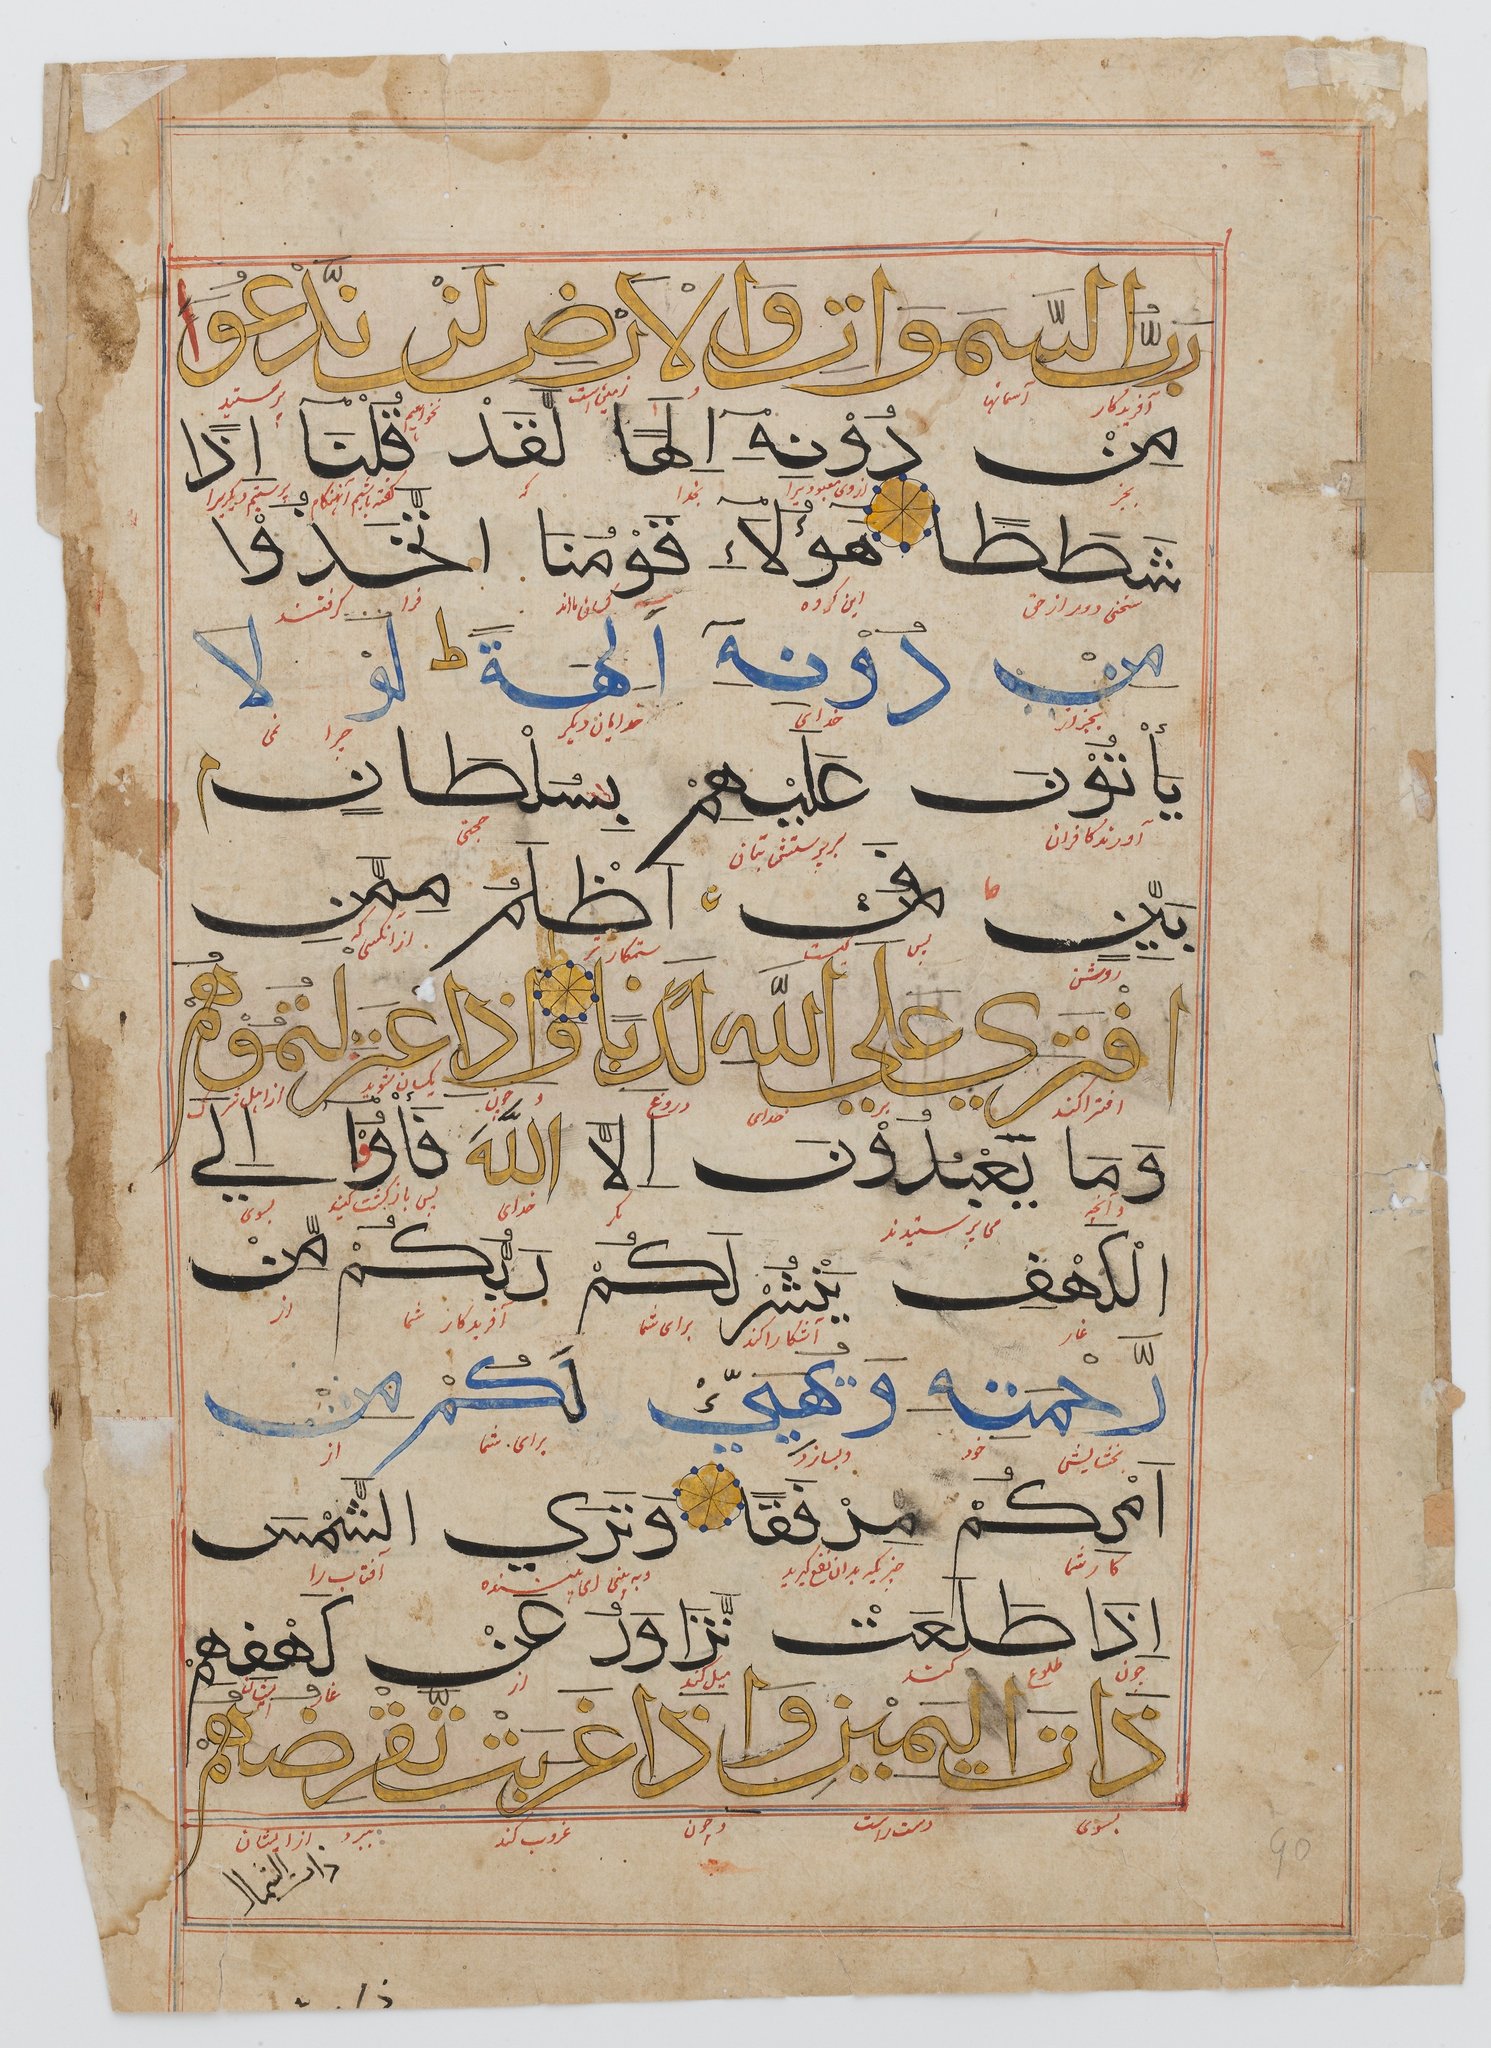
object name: folio from a non illustrated manuscript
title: Folio from a Qur'an Manuscript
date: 1467-1533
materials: gold, ink, paper, watercolor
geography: india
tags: qur'an